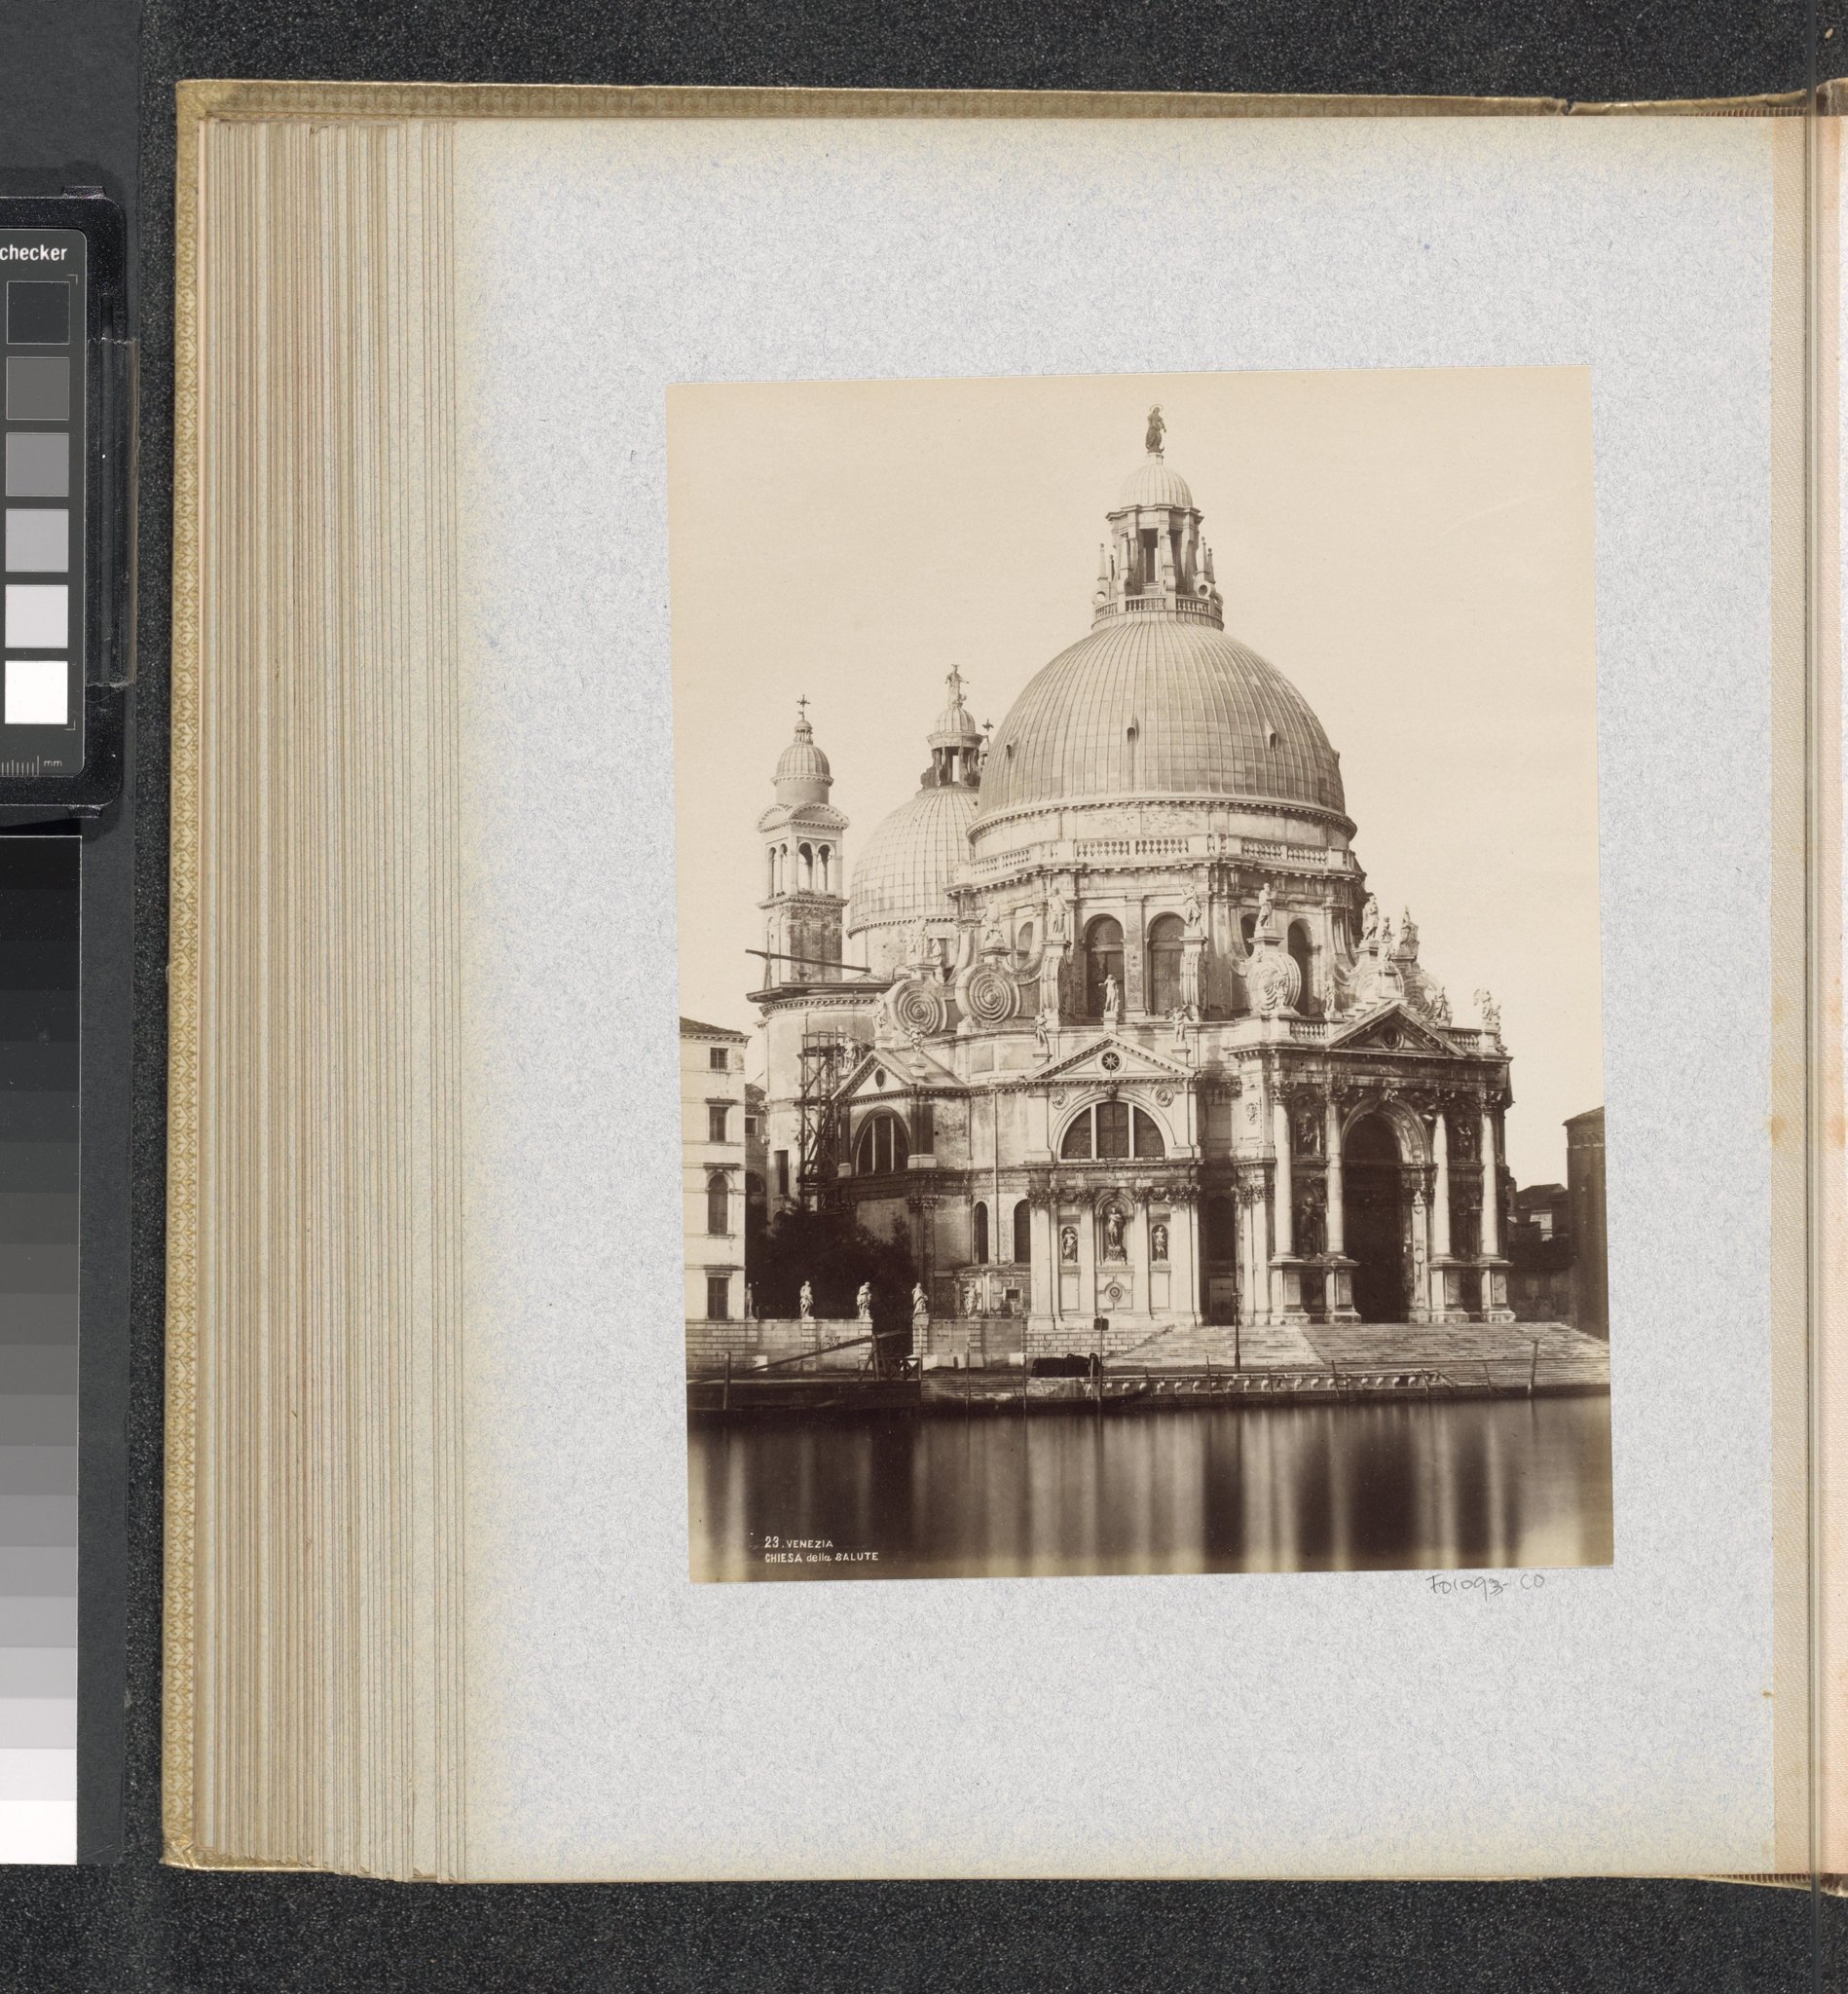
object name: photograph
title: Exterieur van de basiliek van Santa Maria della Salute in Venetië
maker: Anonymous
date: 1870-1890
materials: paper, photographic support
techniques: albumen print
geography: venice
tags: parts of church interior: dome, church (exterior), venice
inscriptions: negative number: ‘23’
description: Onderdeel van Reisalbum met foto's van bezienswaardigheden in Genua, Florence en Venetië.